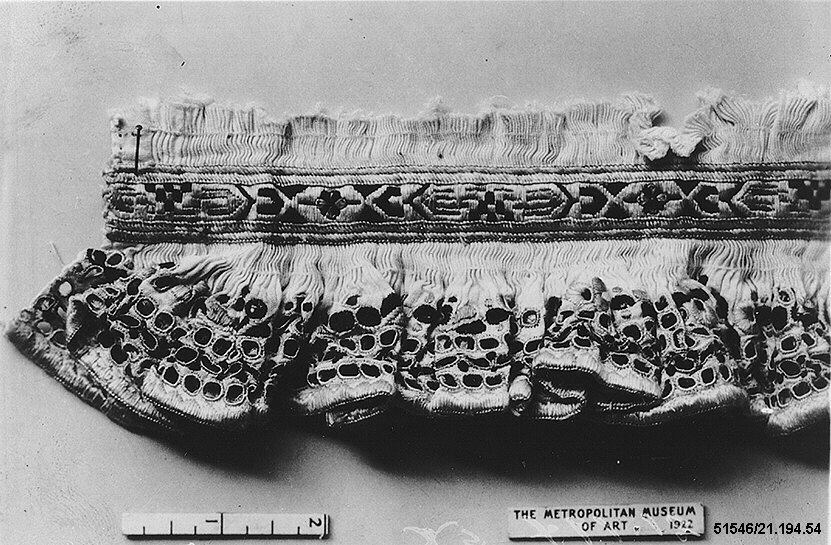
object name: cuff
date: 1801-1900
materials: linen, silk